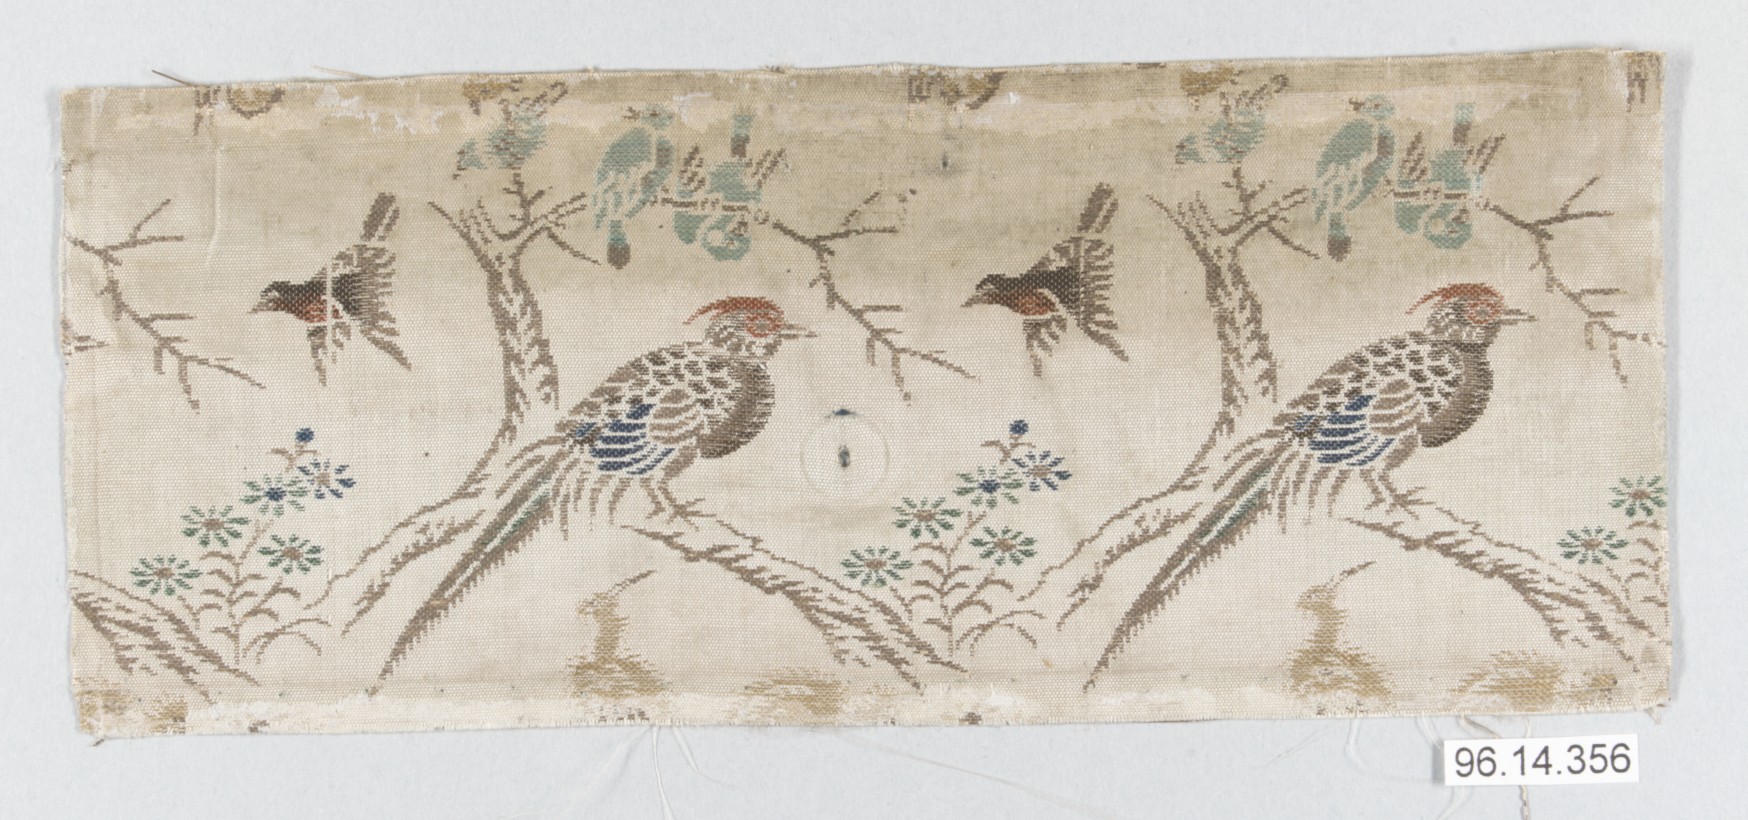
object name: piece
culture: japanese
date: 1701-1900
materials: silk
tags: flowers